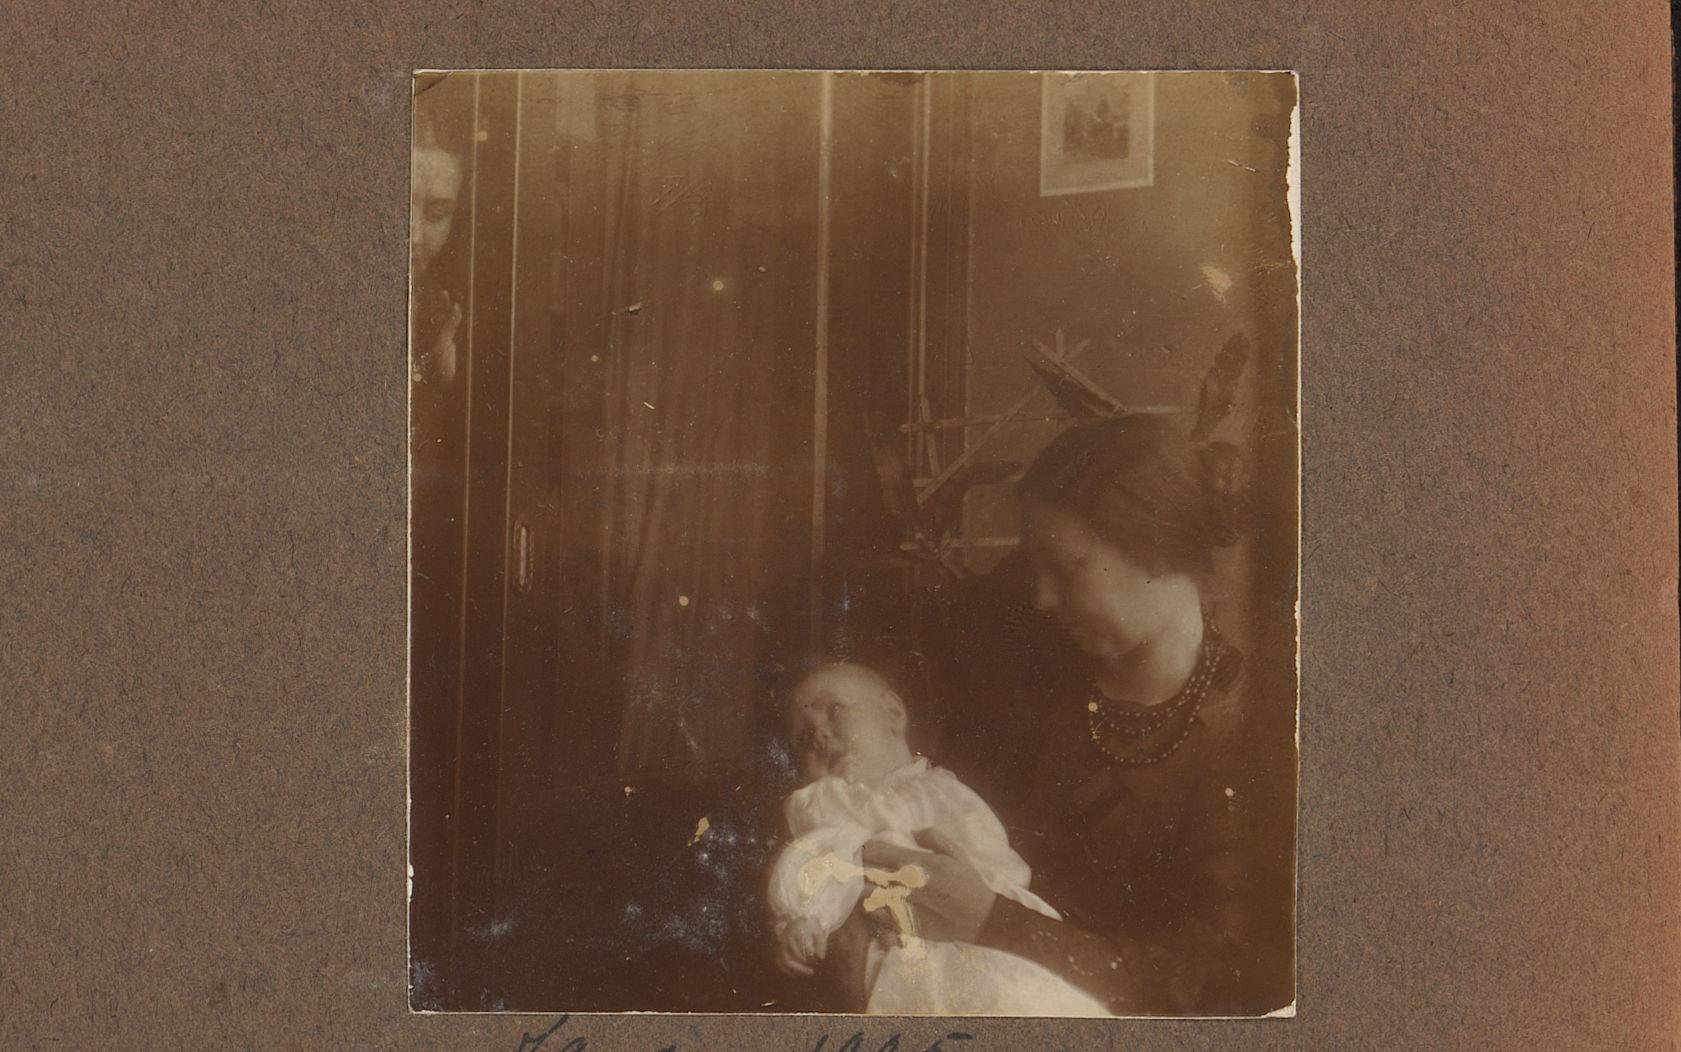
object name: photograph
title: Mevrouw Diepenbrock met kind op schoot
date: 1905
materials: photographic support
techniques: photography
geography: amsterdam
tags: jonkvrouw wilhelmina elisabeth petronella cornelia de jong van beek en donk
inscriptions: date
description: Foto op bruin albumblad 3 van familiealbum van Alphons Diepenbrock.